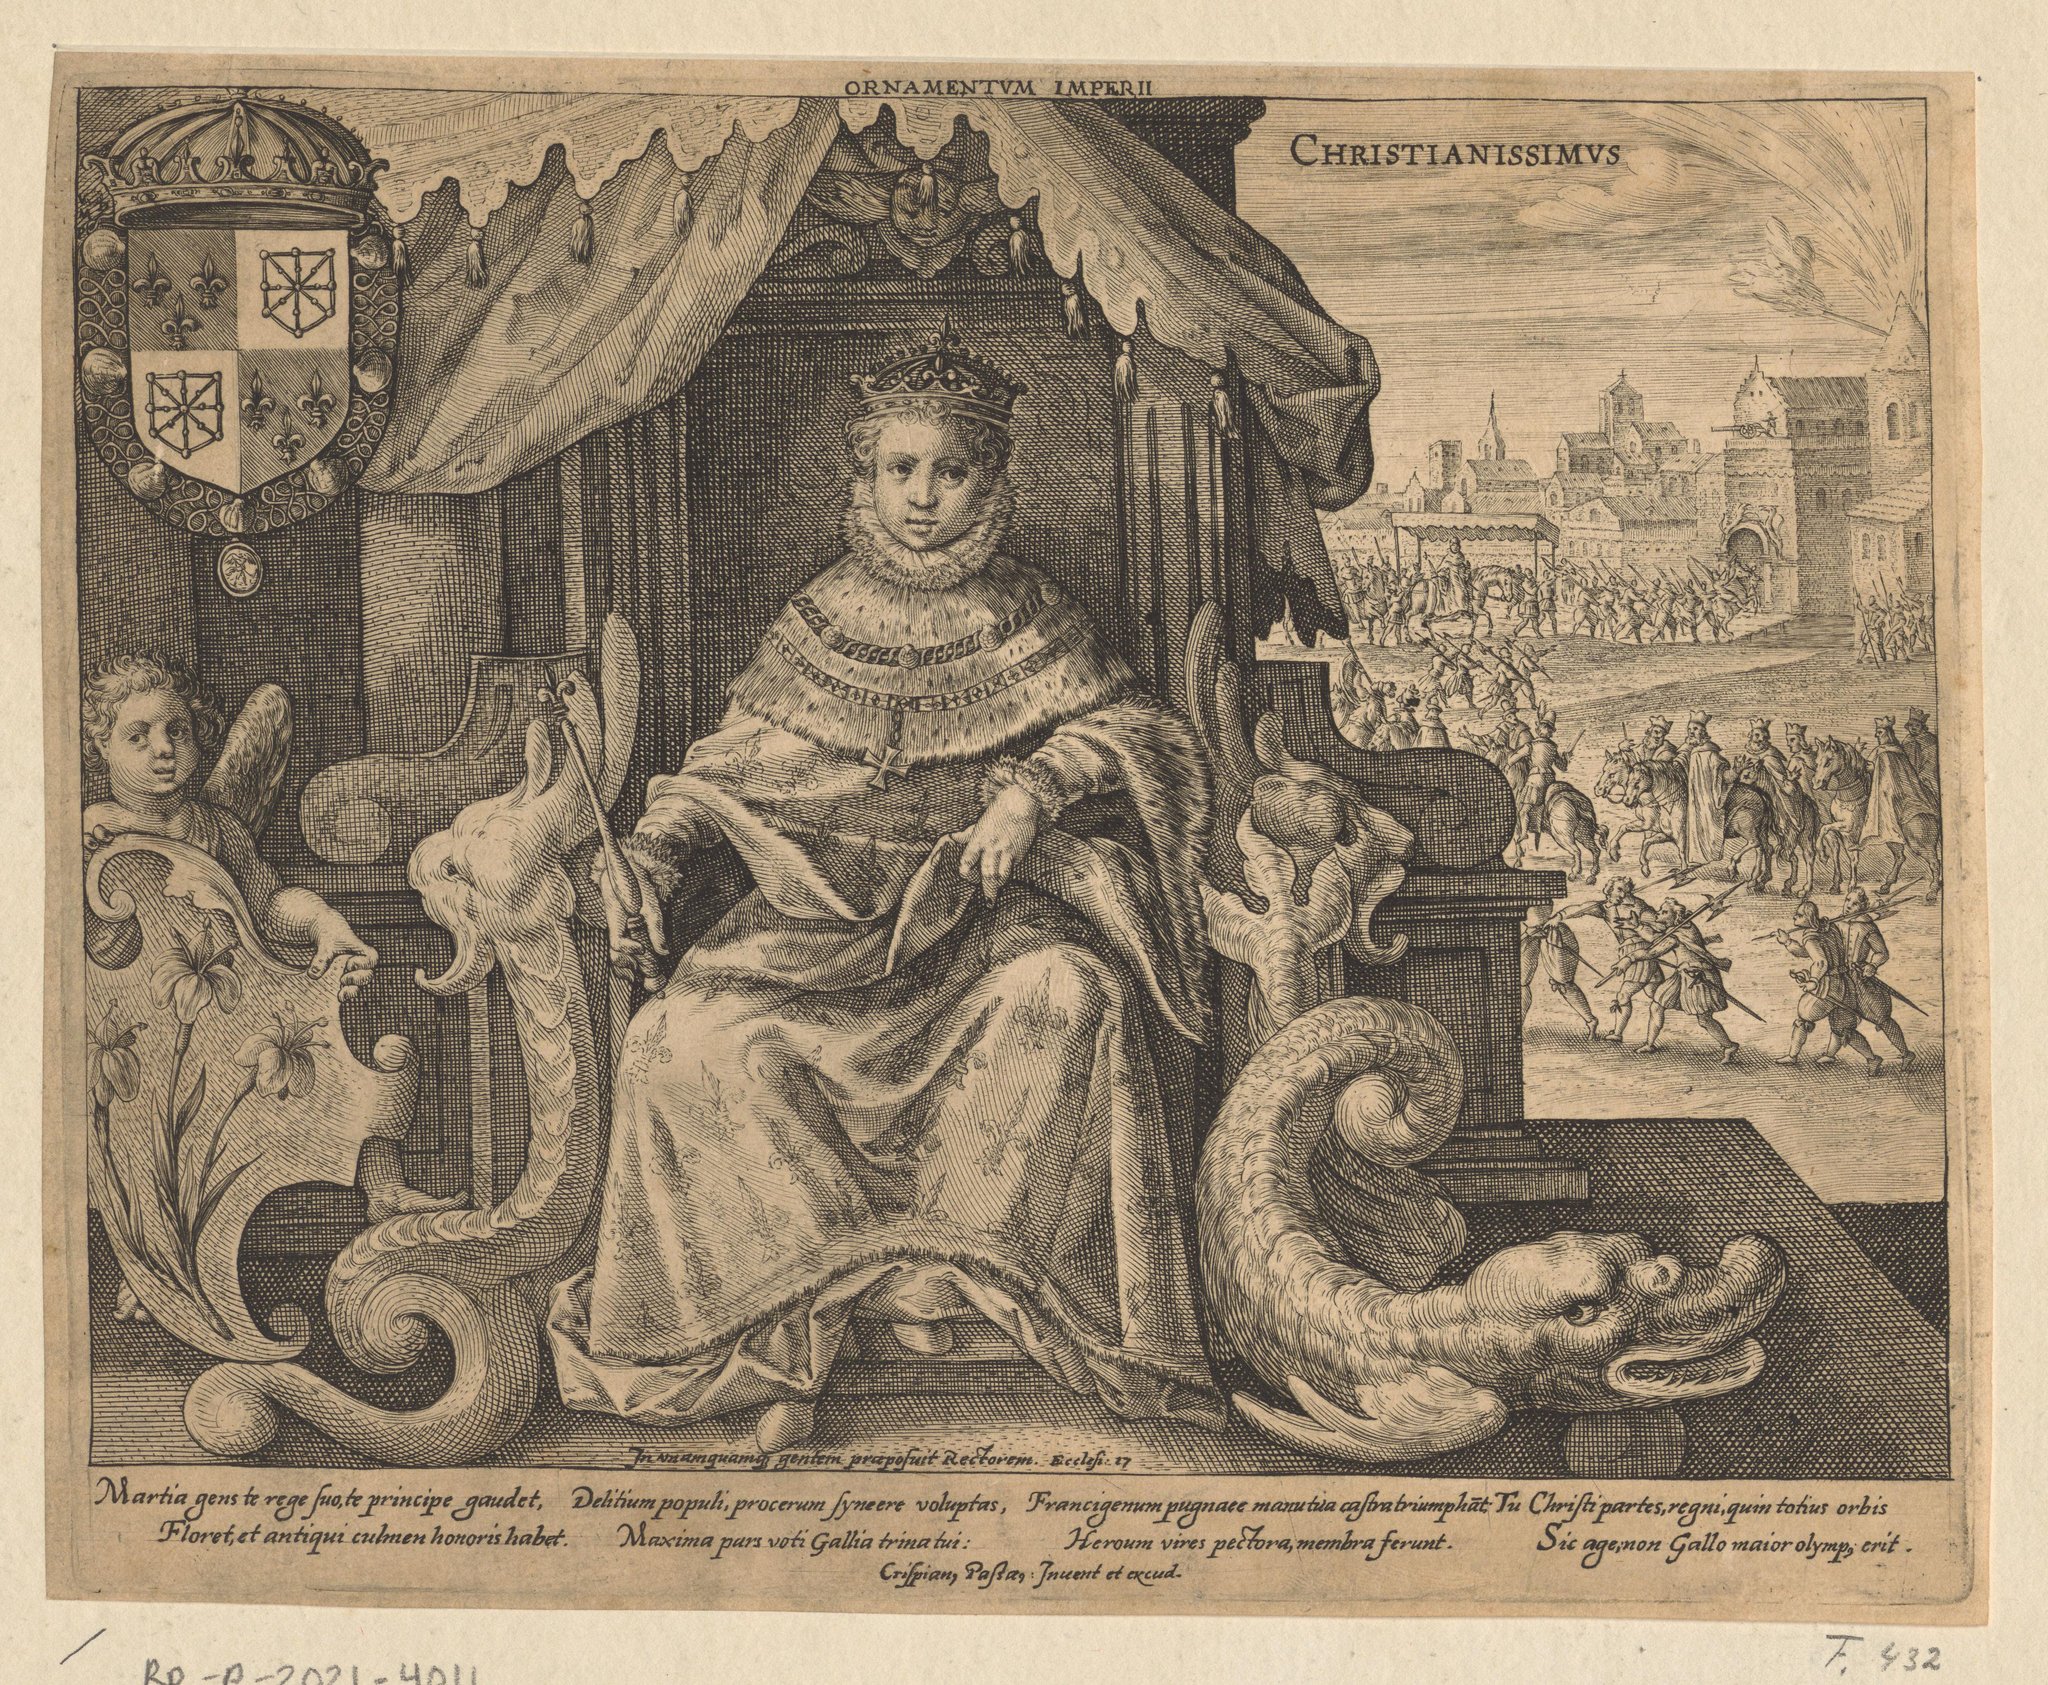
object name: print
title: Portret van Lodewijk XIII van Frankrijk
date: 1611-1614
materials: paper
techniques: engraving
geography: utrecht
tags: lodewijk xiii (koning van frankrijk), triumphal entry and public reception, pageant, 'entrée solennelle', 'joyeuse entrée', historical persons, throne, king, armorial bearing, heraldry, royal mantle (symbol of sovereignty)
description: Lodewijk XIII als kind op een troon. In zijn rechterhand houdt hij een scepter. Linksboven zijn wapenschild. Naast de troon staat een engel met een wapenschild met drie lelies. Op de achtergrond de feestelijke intocht van Lodewijk XIII. Midden onder een Bijbelcitaat uit Pr. 17 in het Latijn. In de marge een achtregelig lofdicht, in vier kolommen, in het Latijn.